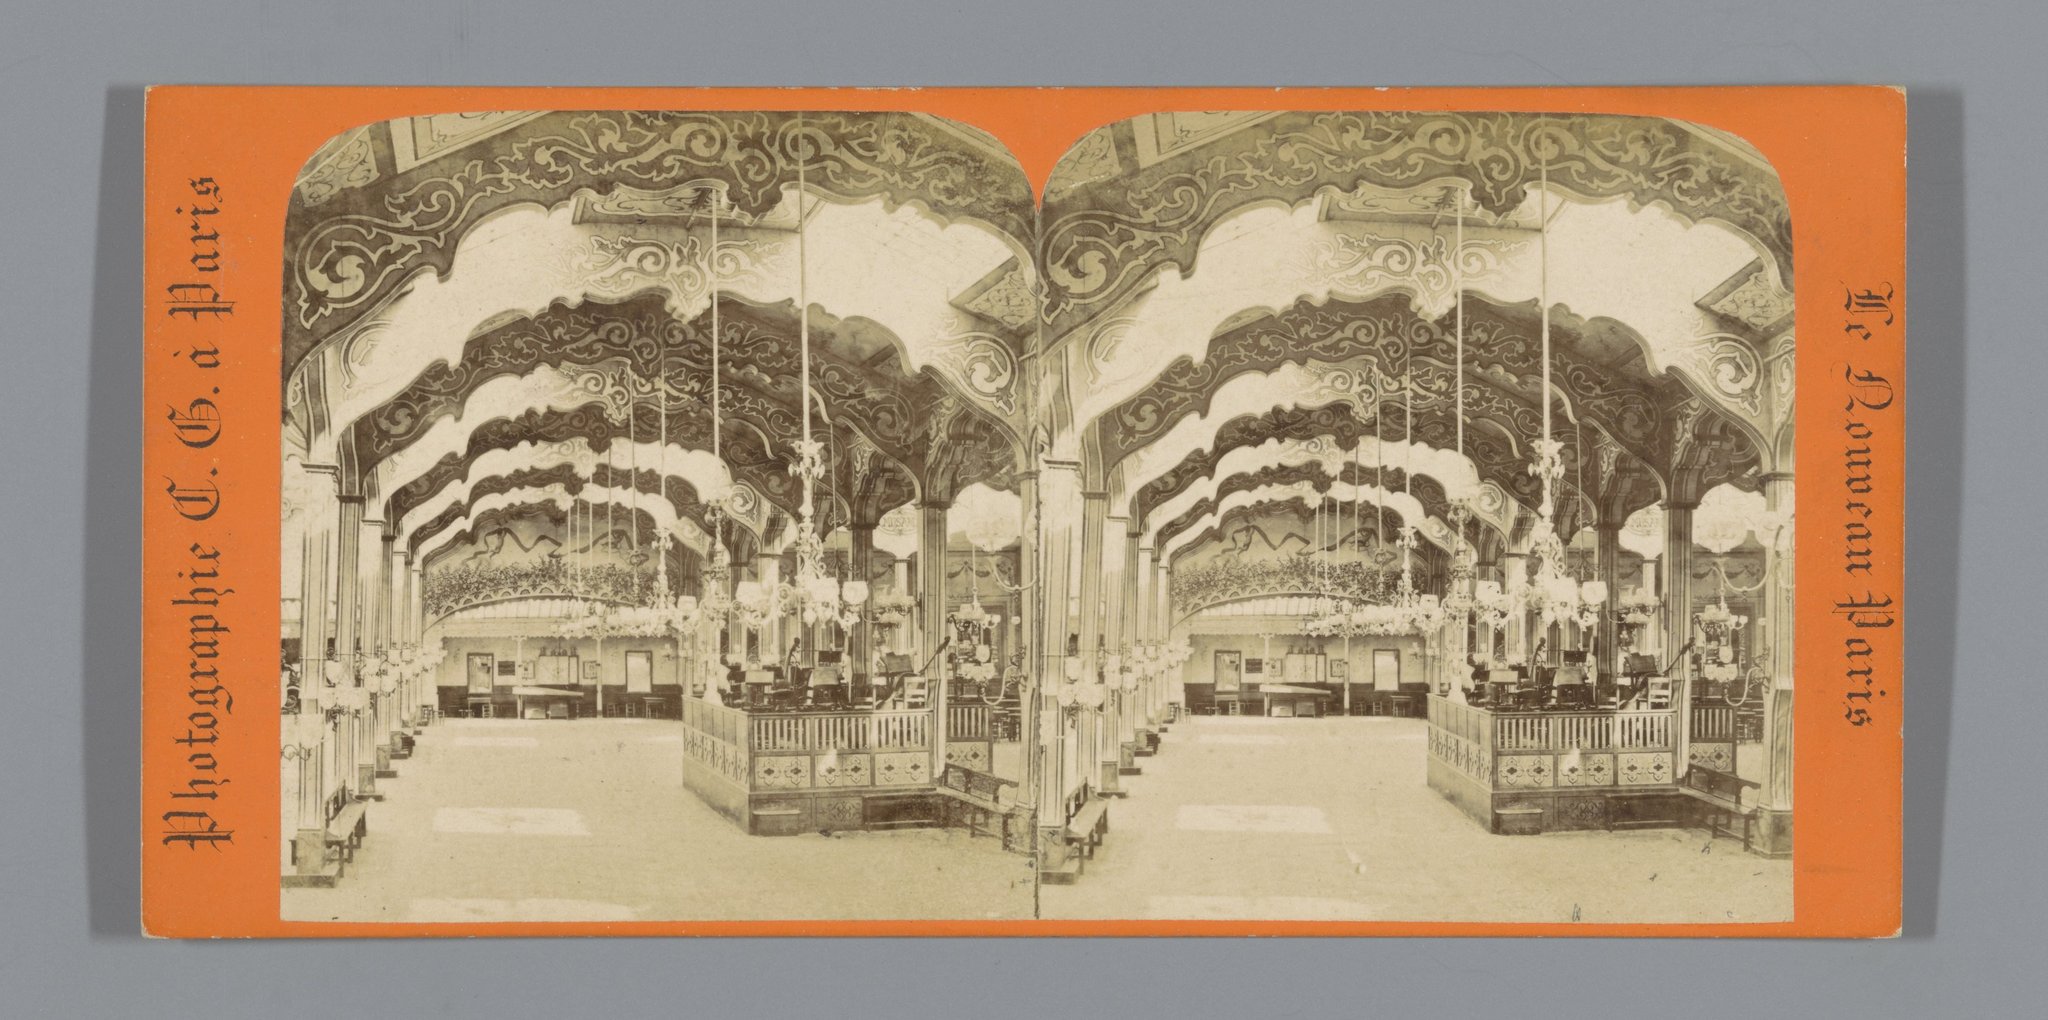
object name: stereograph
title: Le Nouveau Paris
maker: charles gérard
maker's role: fotograaf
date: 1850-1875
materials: cardboard, photographic support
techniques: albumen print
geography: bal bullier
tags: night-club, dance-hall, interior ~ representation of a building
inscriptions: inscription: ‘Bal Bullier Paris’